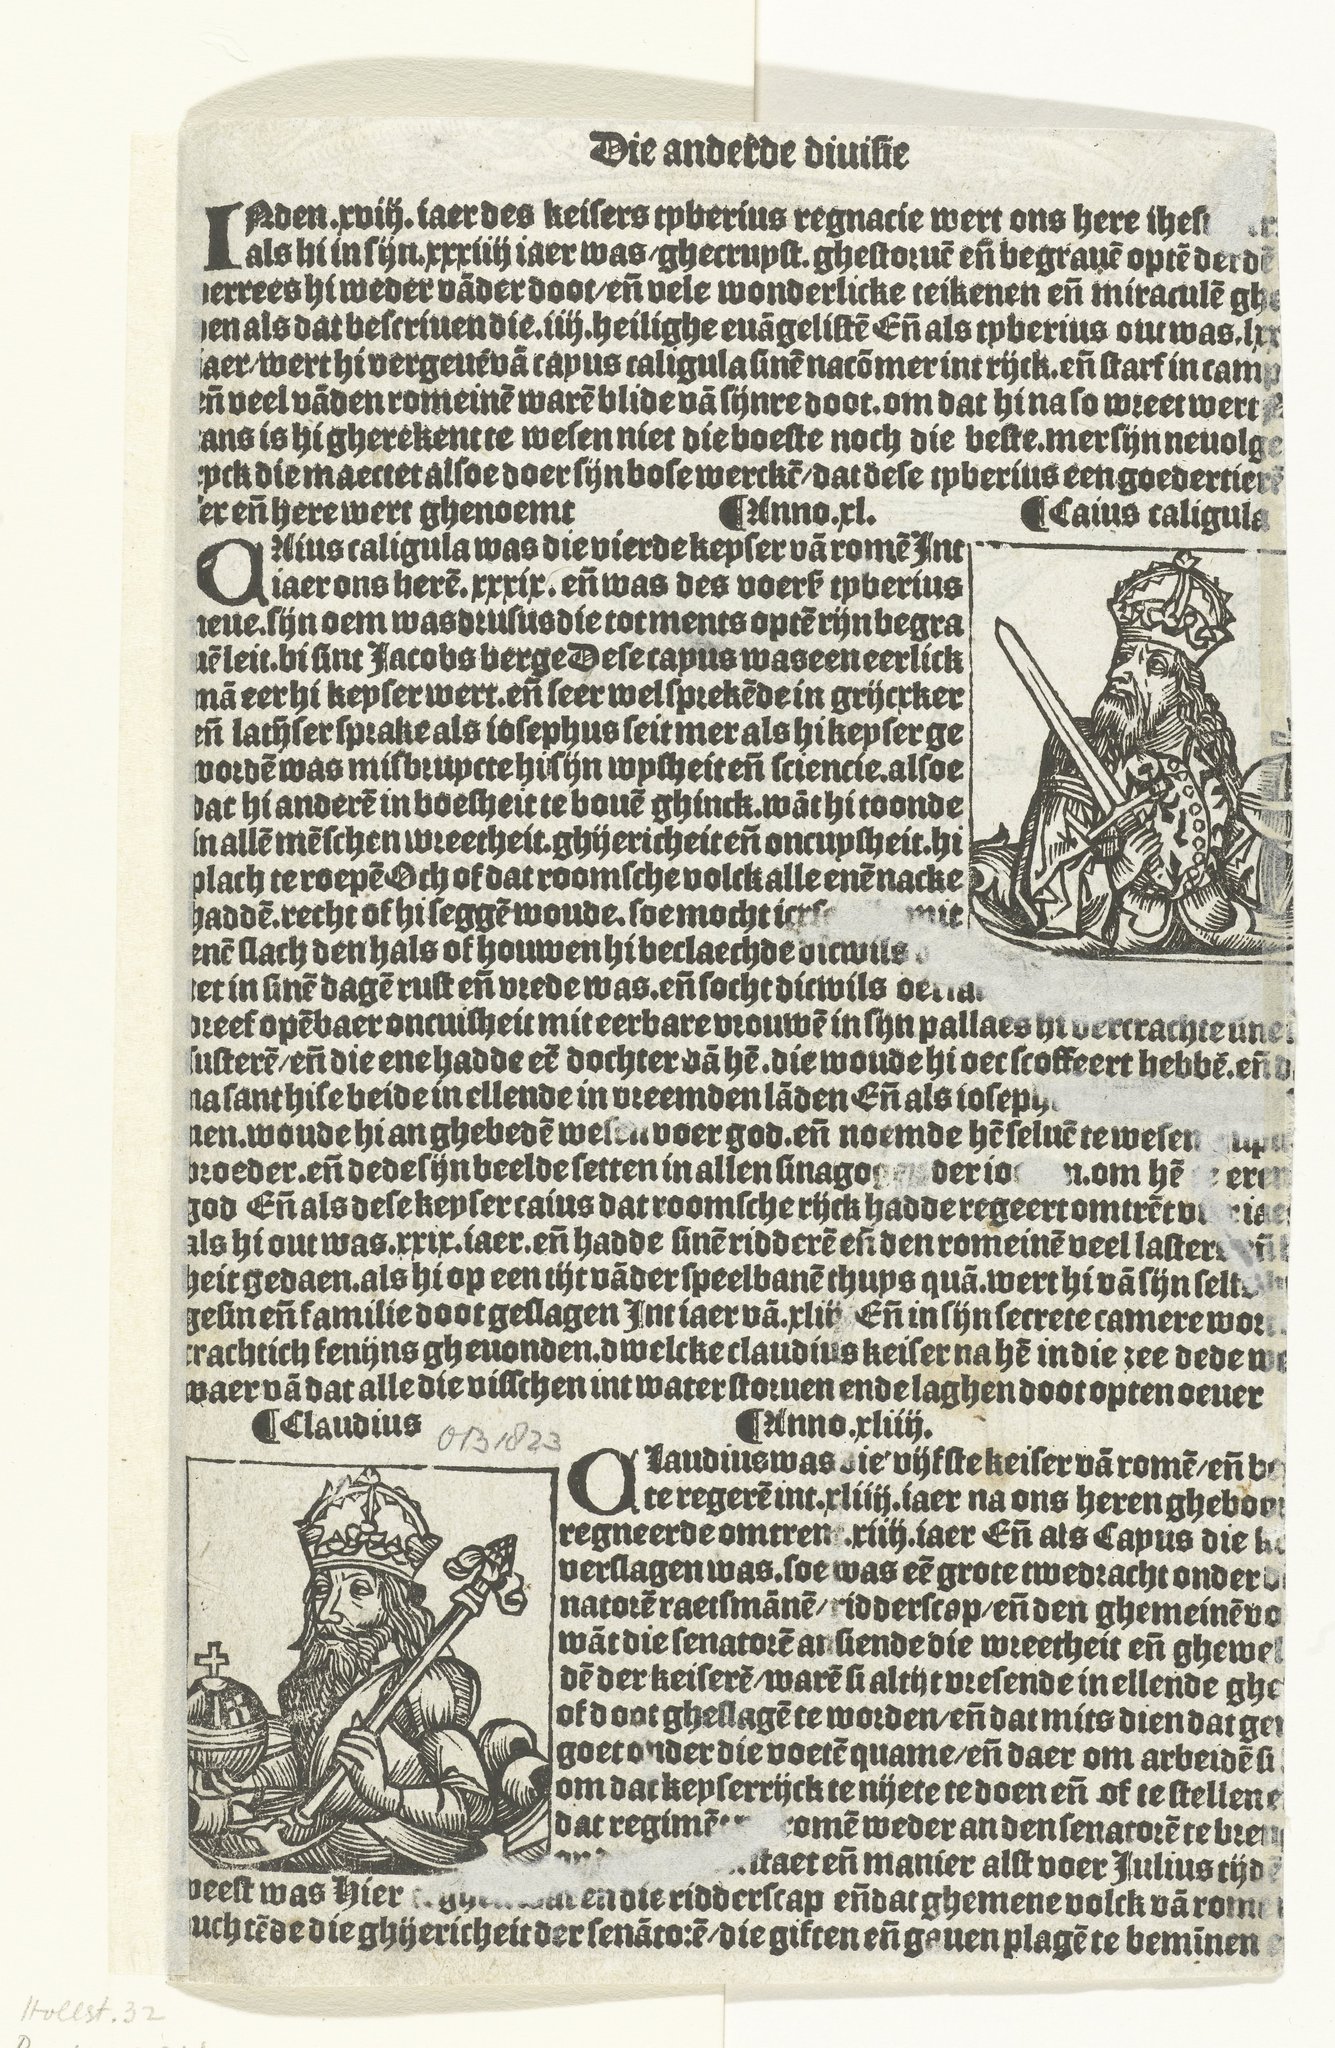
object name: print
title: Twee portretten van Romeinse keizers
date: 1517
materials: paper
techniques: woodcut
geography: leiden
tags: germany, rome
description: Uit "Cronycke van Hollandt, Zeelandt ende Vrieslant", uitgegeven door Jan Seversz. te Leiden. Houtsnede gebruikt in de editie van 1517 en van 1517-1530, folio 28v.